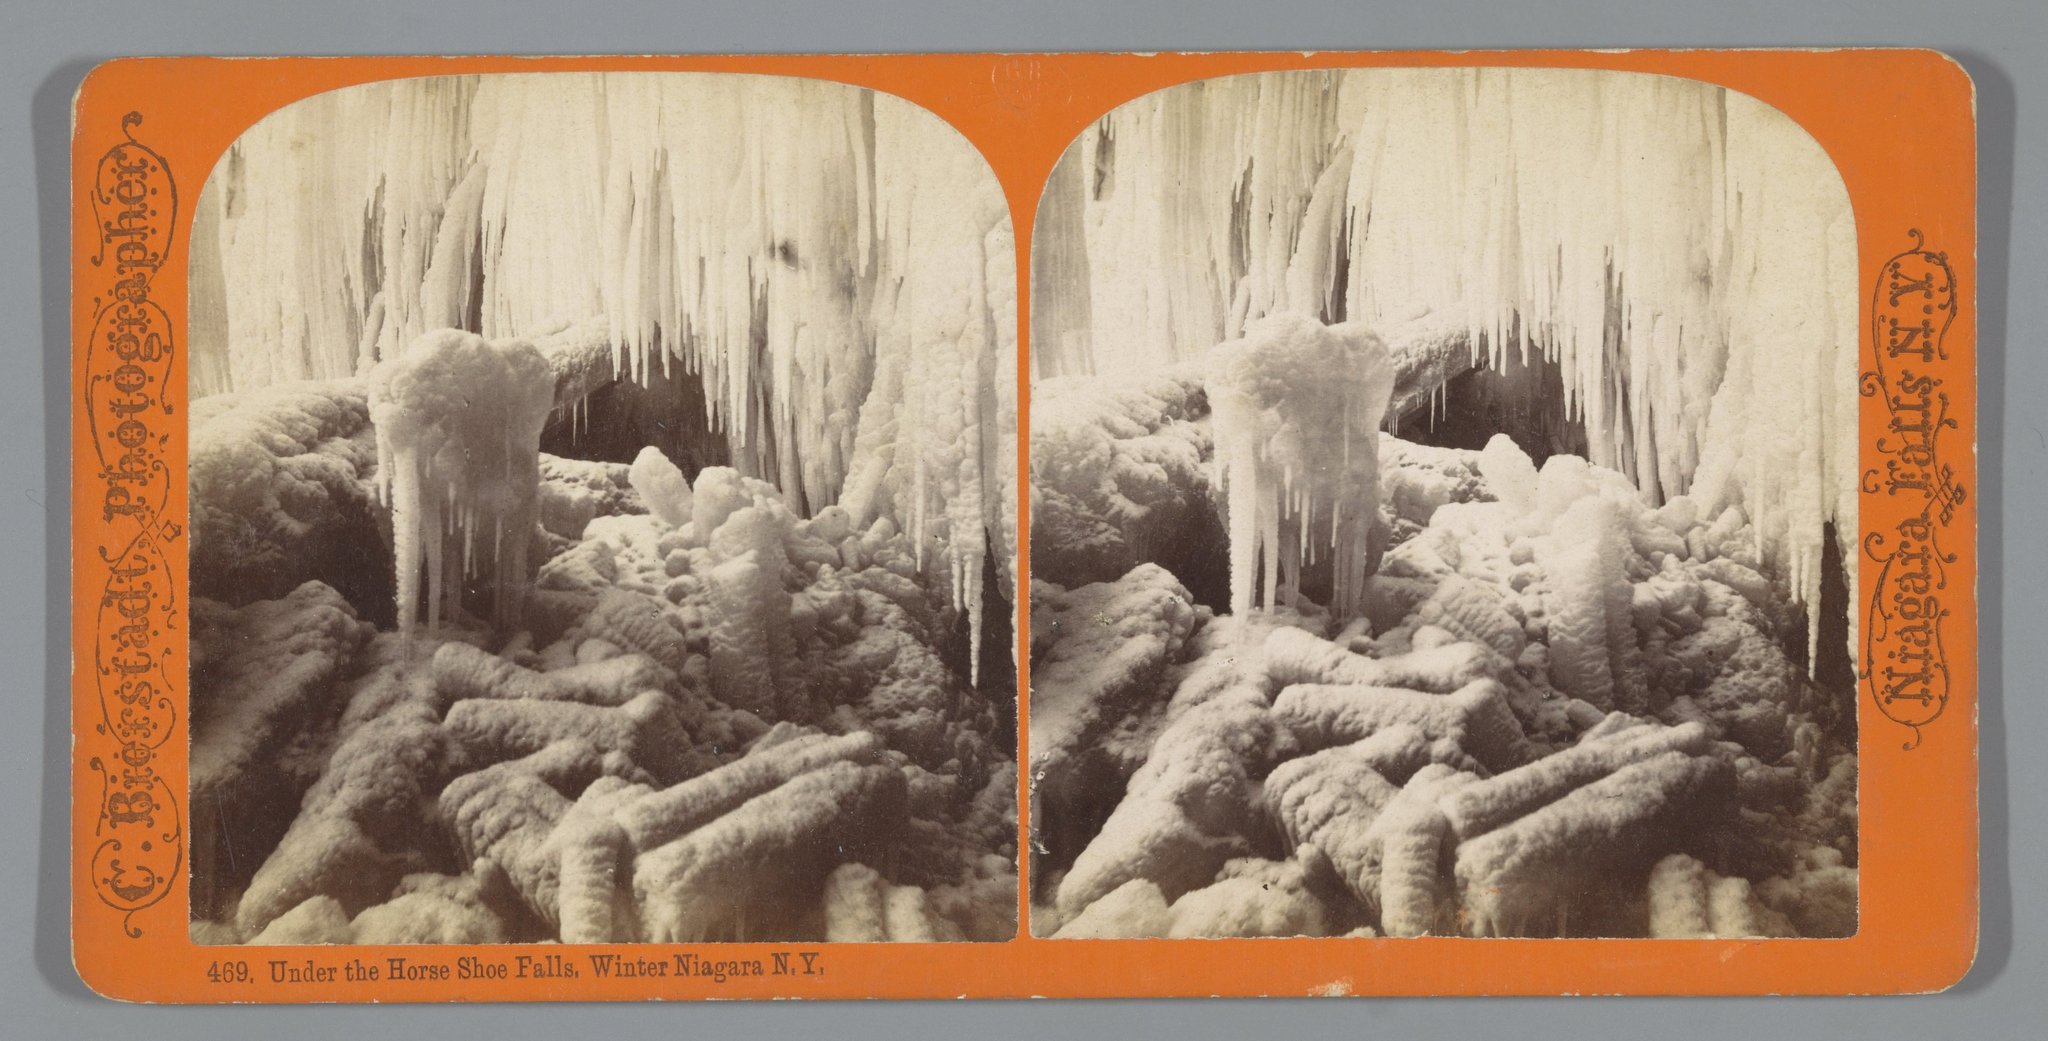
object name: stereograph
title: Under the Horse Shoe Falls, Winter Niagara N.Y.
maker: charles bierstadt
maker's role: publisher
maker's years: 1819-1903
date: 1867-1891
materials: cardboard, paper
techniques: albumen print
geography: horseshoe falls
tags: stalactitic cave, icicle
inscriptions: number: ‘469’, initials: ‘C.B.’, inscription: ‘Niagara Falls N.Y.’